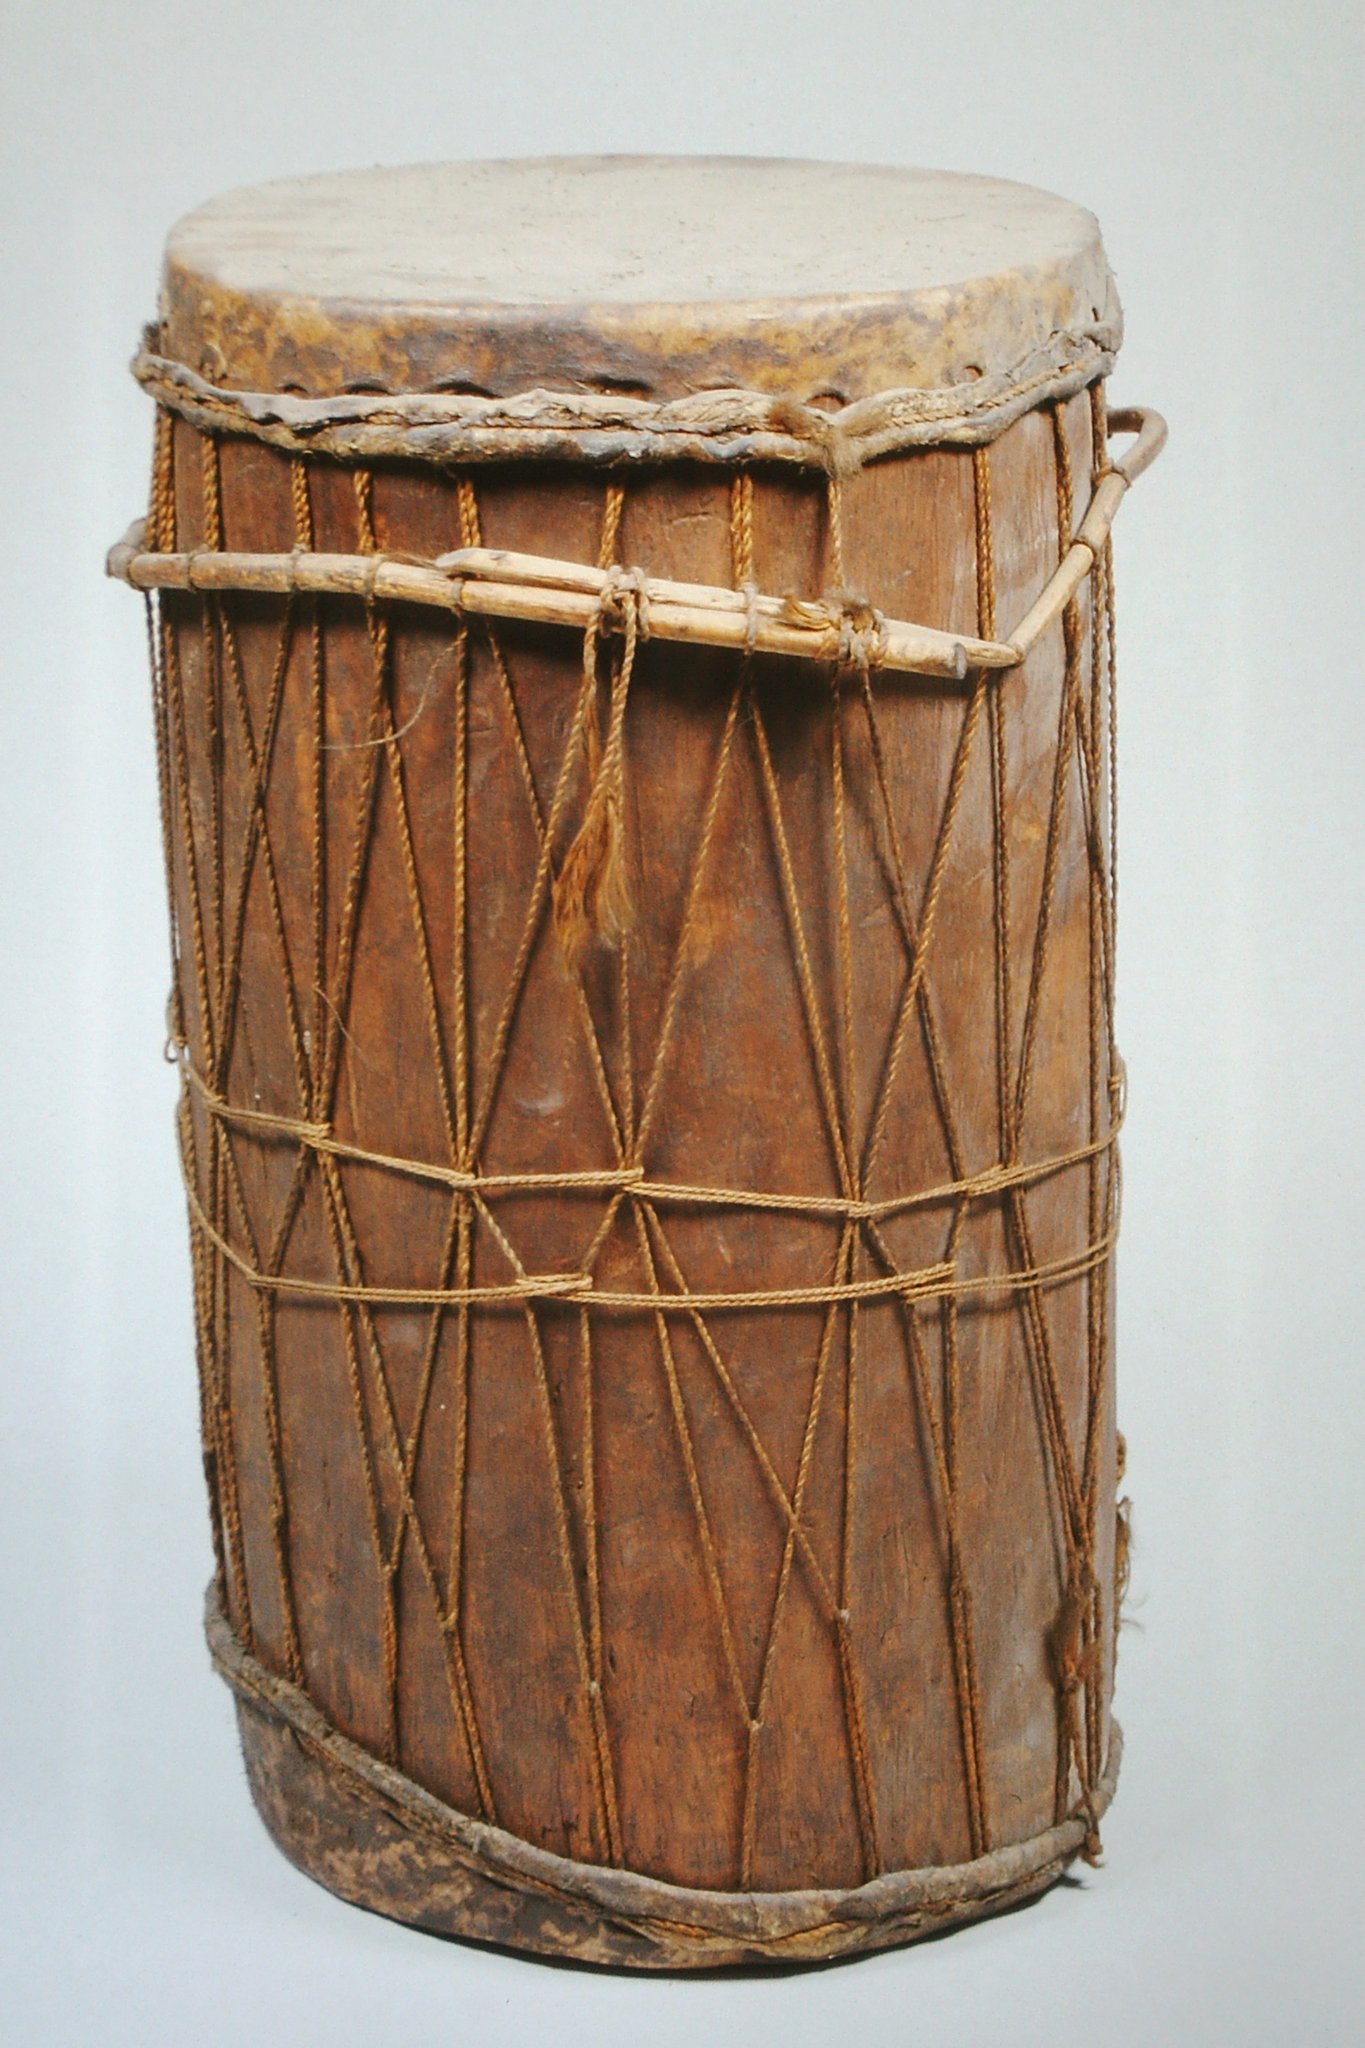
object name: drum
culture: african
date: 1801-1900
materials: wood